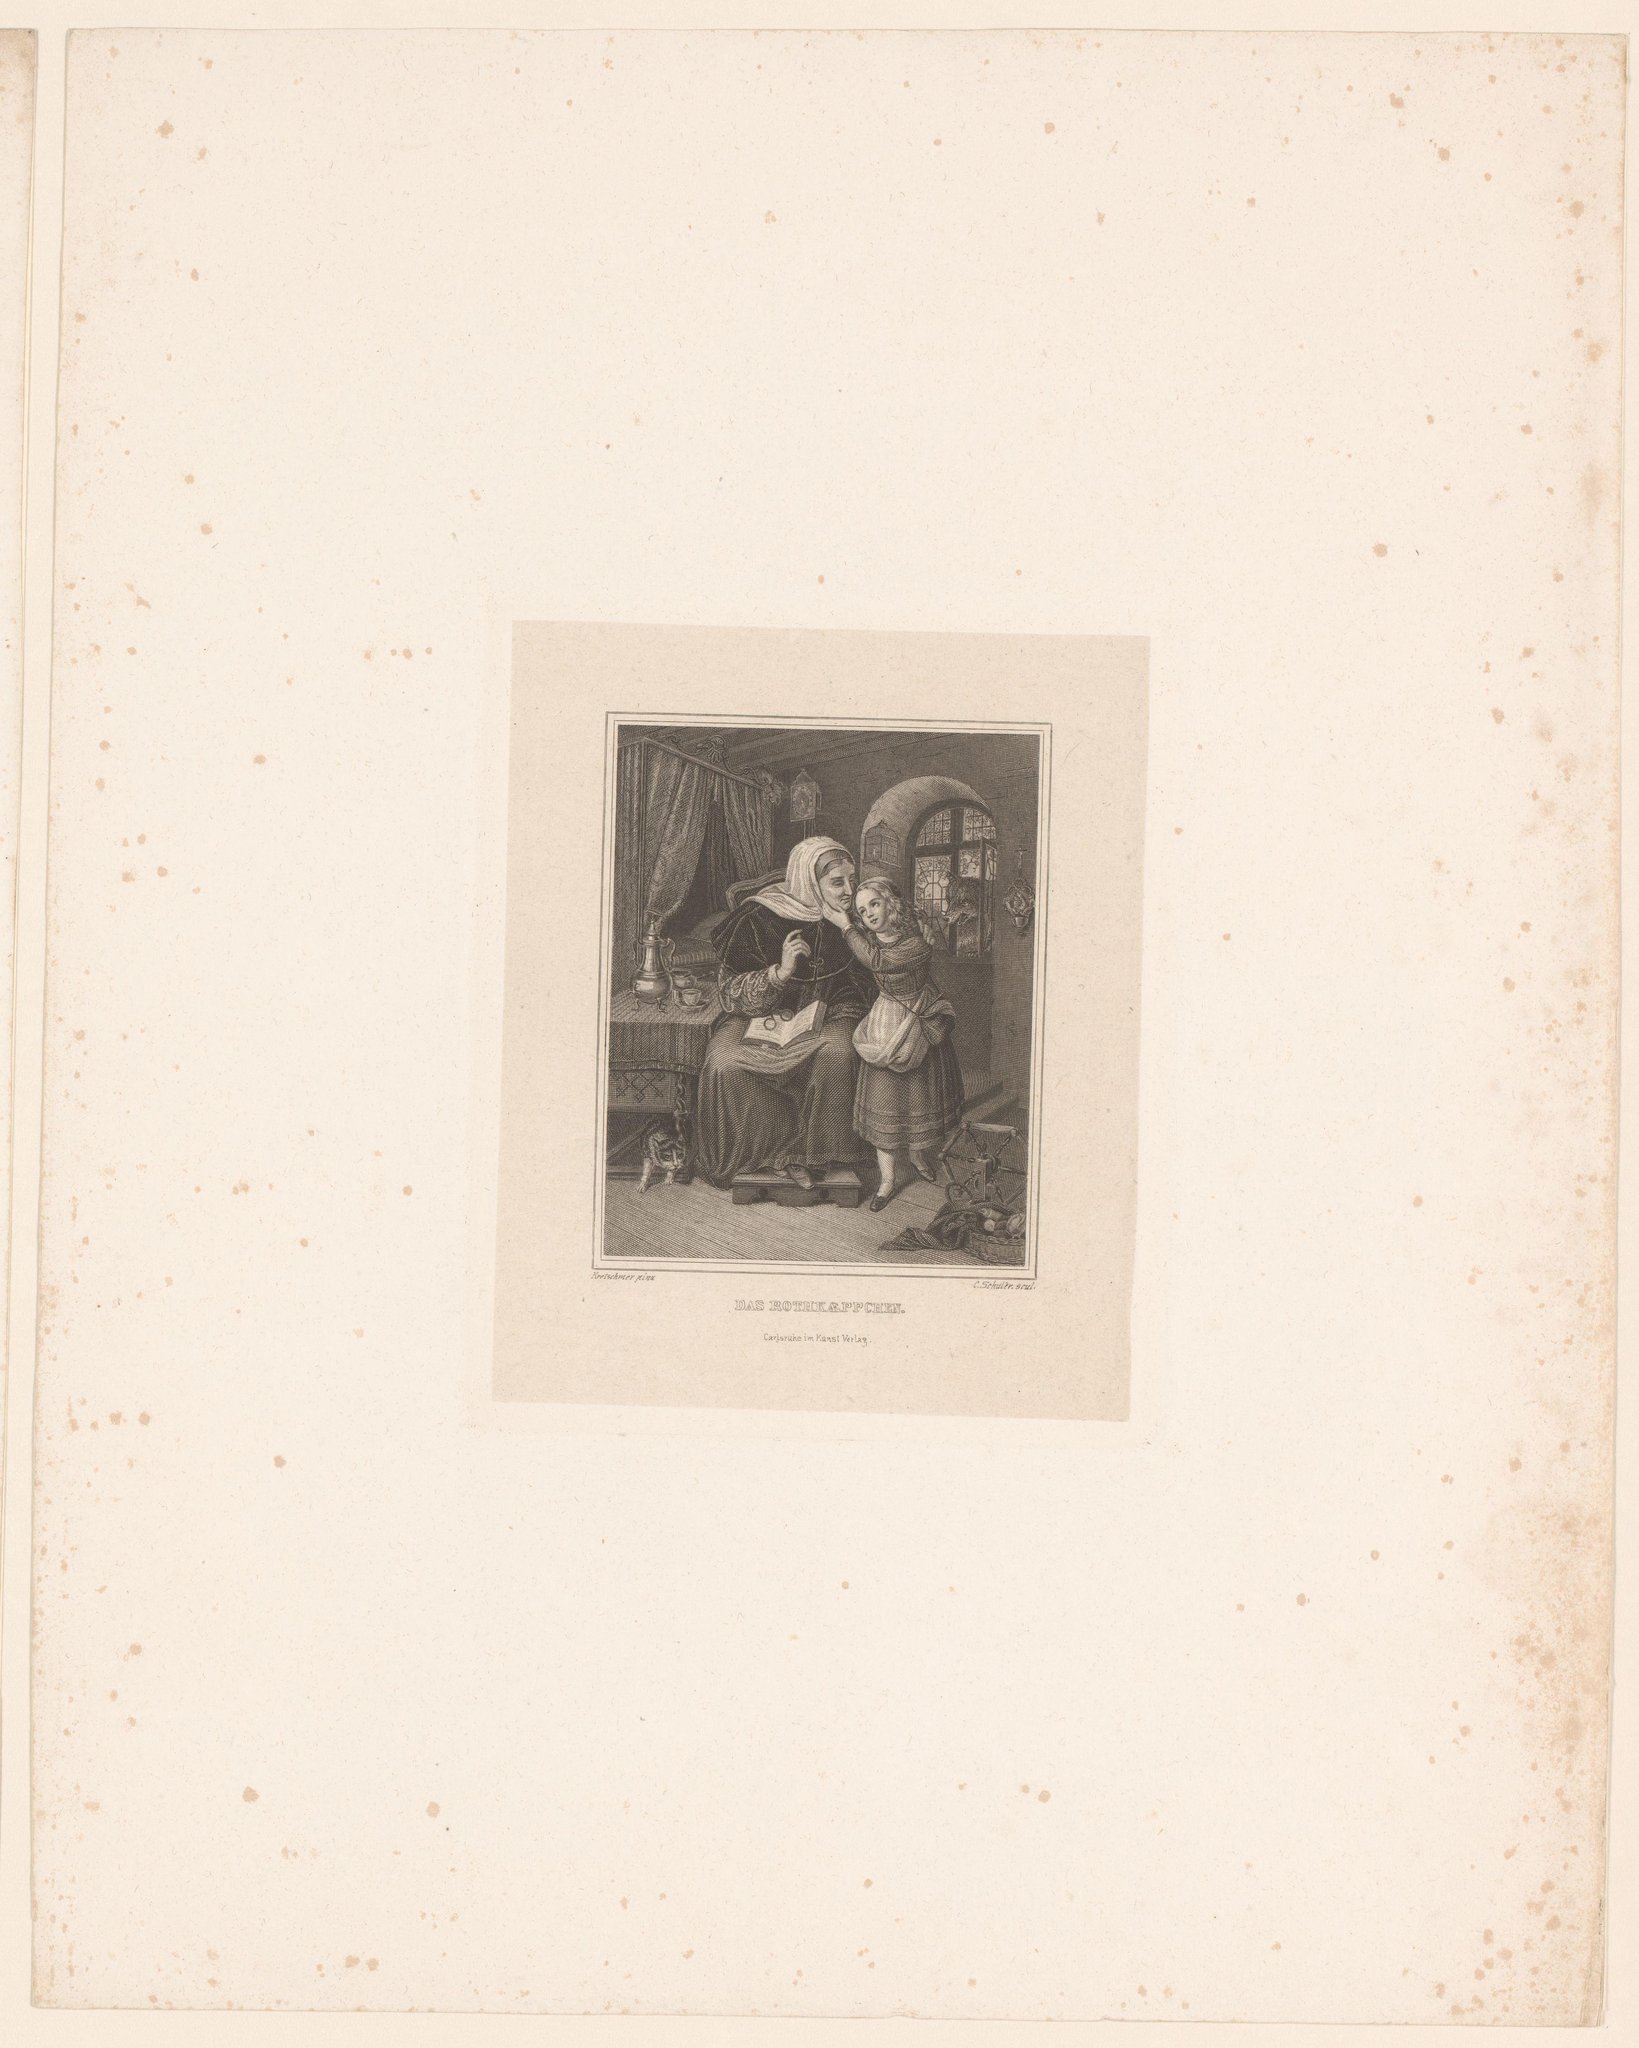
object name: print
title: Das Rothkappchen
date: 1814-1859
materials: paper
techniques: engraving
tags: tales and fairy tales: little red riding-hood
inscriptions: collector's mark: Lugt 2228